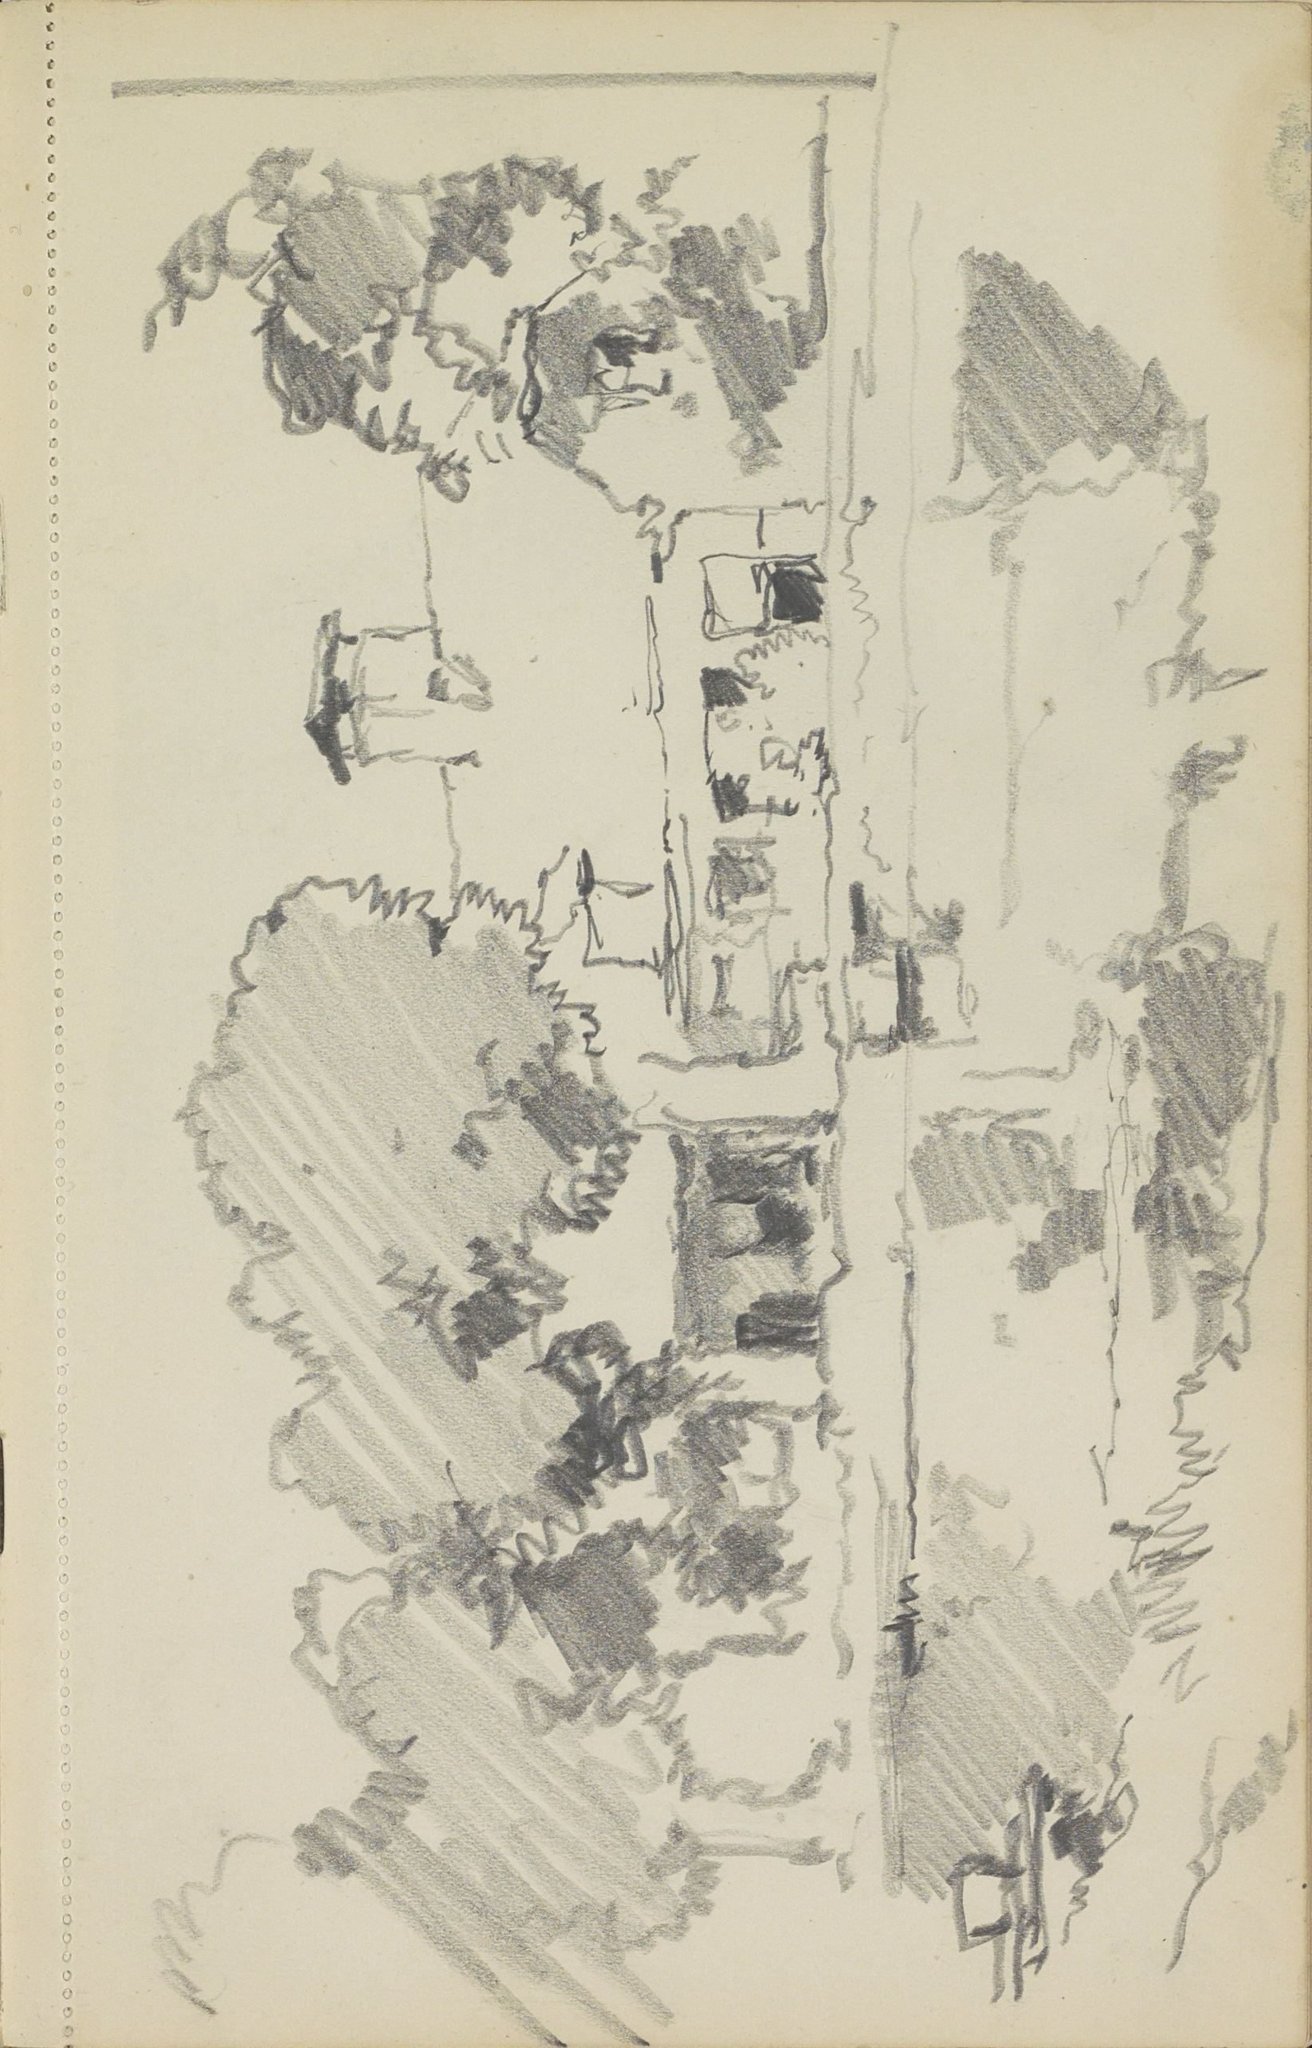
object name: sketchbook leaf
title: Huis aan een waterkant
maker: cornelis vreedenburgh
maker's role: draughtsman, print maker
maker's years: 1880-1946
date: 1890-1946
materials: paper, pencil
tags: landscapes with waters, waterscapes, seascapes (in the temperate zone), housing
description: Blad 28 recto uit een schetsboek met 56 bladen.